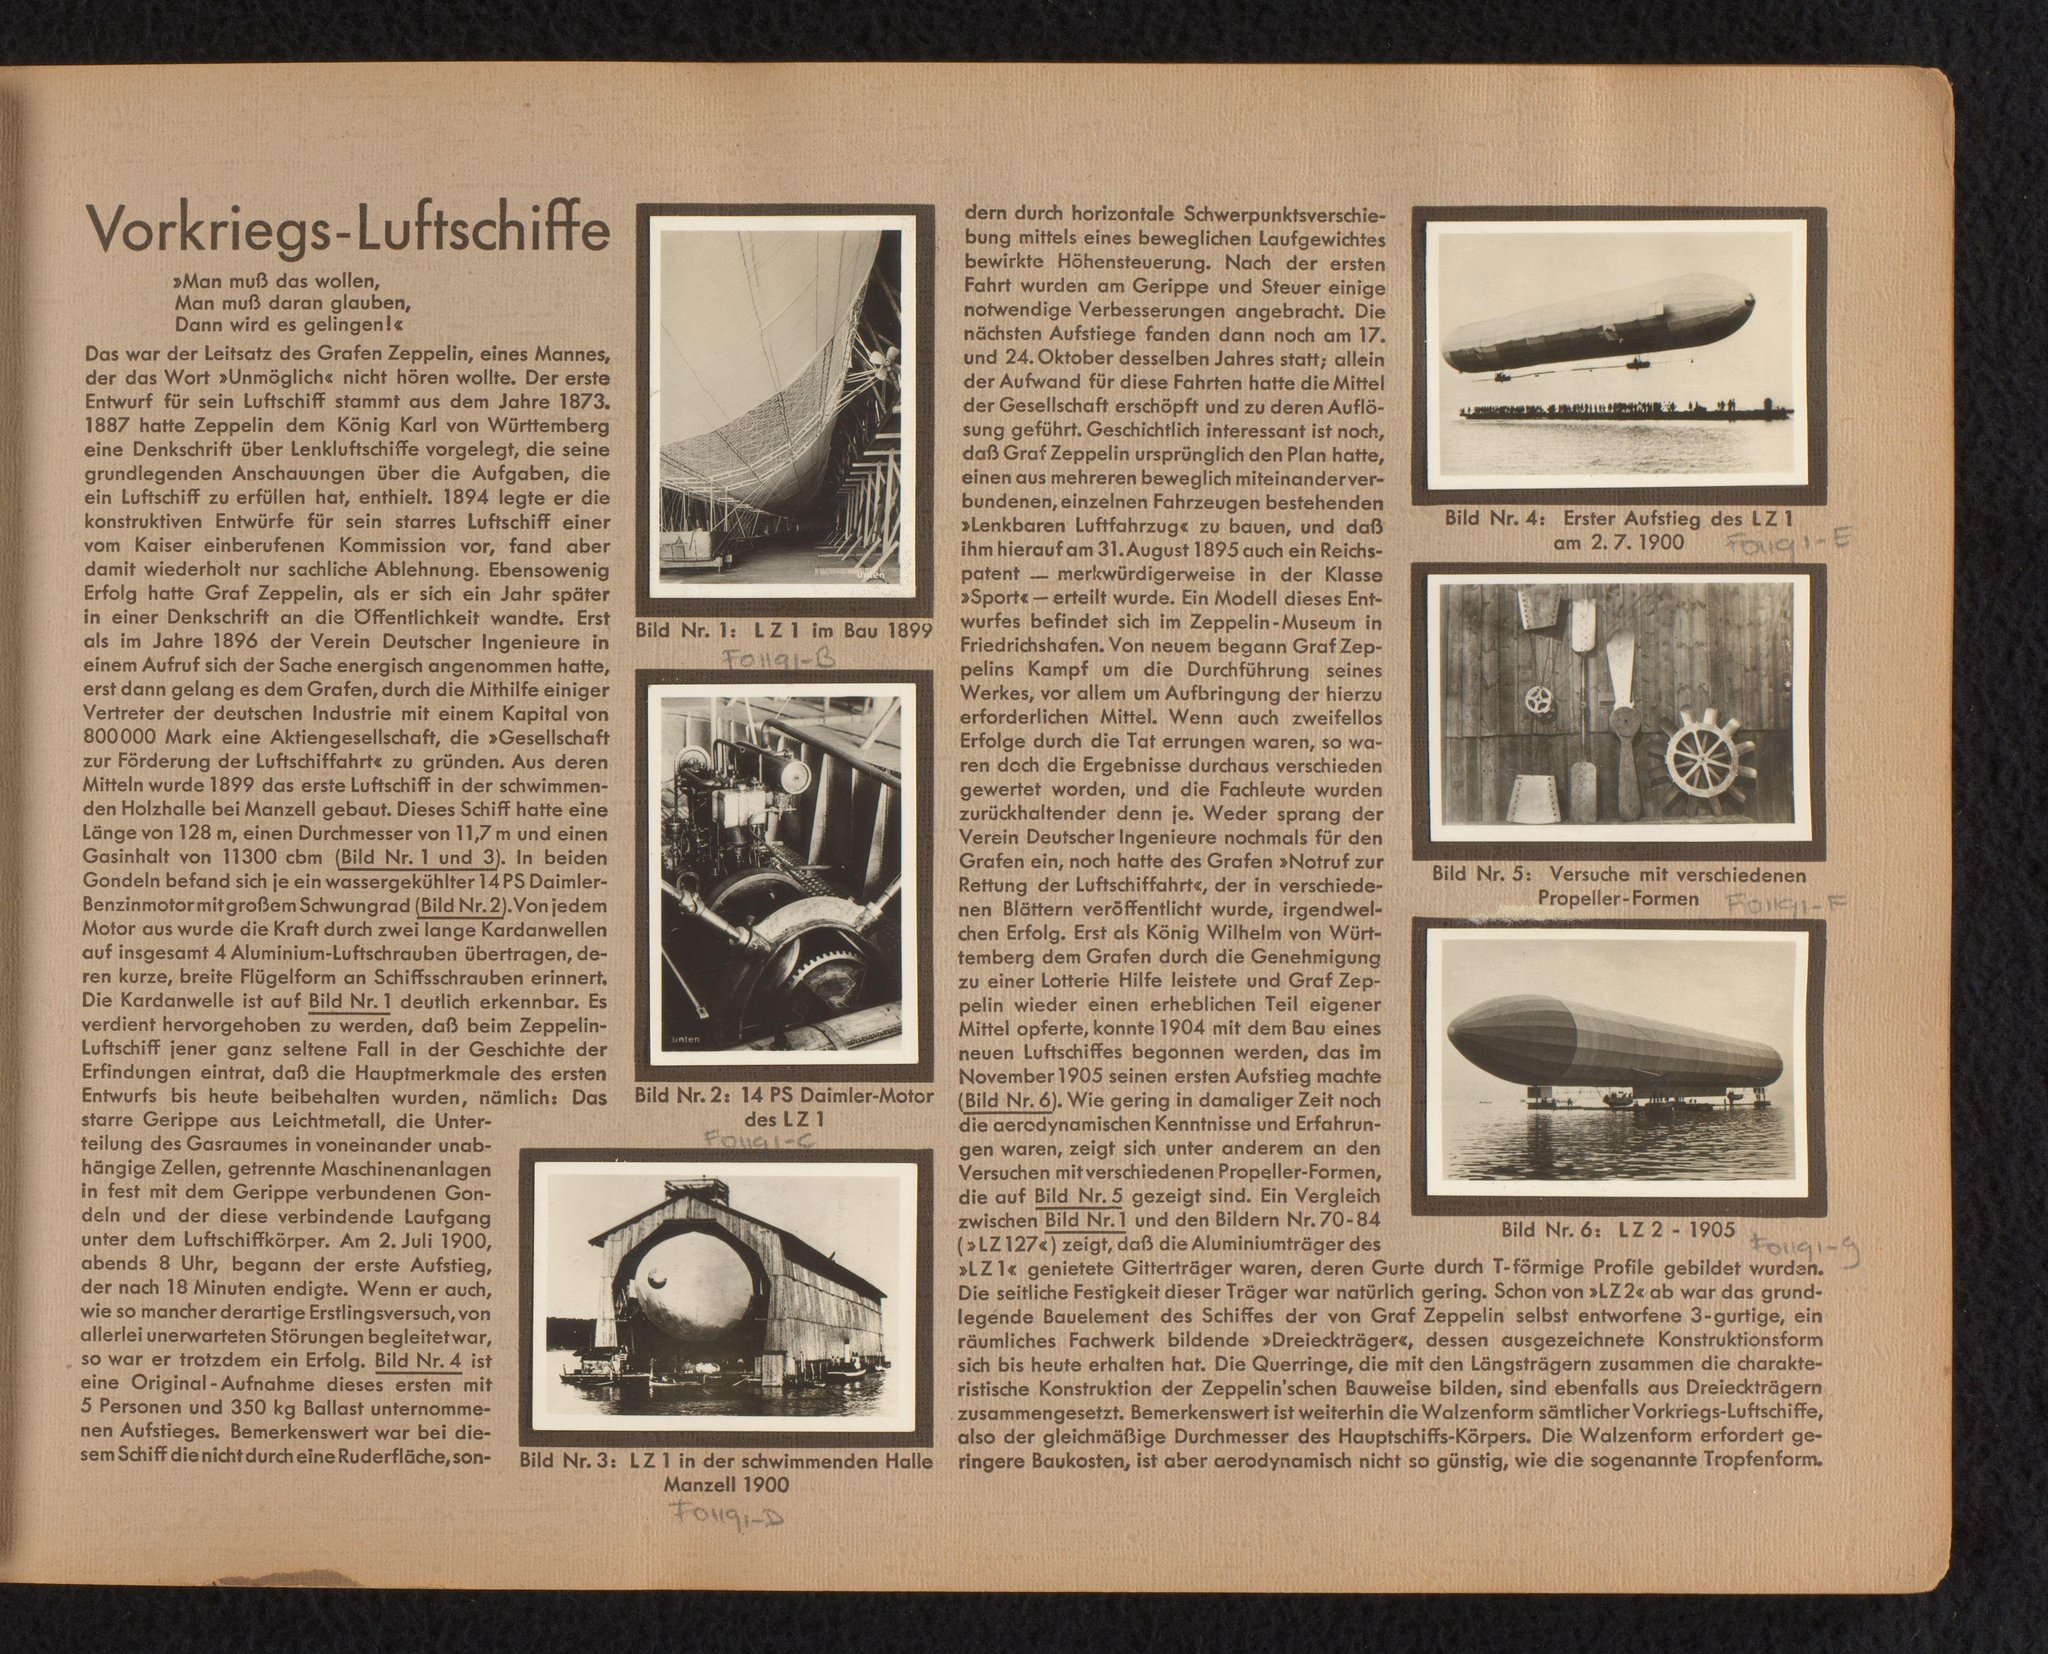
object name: album leaf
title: Vorkriegs-Luftschiffe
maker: Anonymous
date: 1899-1905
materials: paper, photographic support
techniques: gelatin silver print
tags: 46c35 airship, zeppelin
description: Pagina met zes foto's van de eerste zeppelin, de LZ1, de bouw, onderdelen en de eerste opstijging hiervan en de bouw van de tweede zeppelin, LZ2. Alle foto's zijn voorzien van een nummer en titel. Deze pagina maakt deel uit van een album.